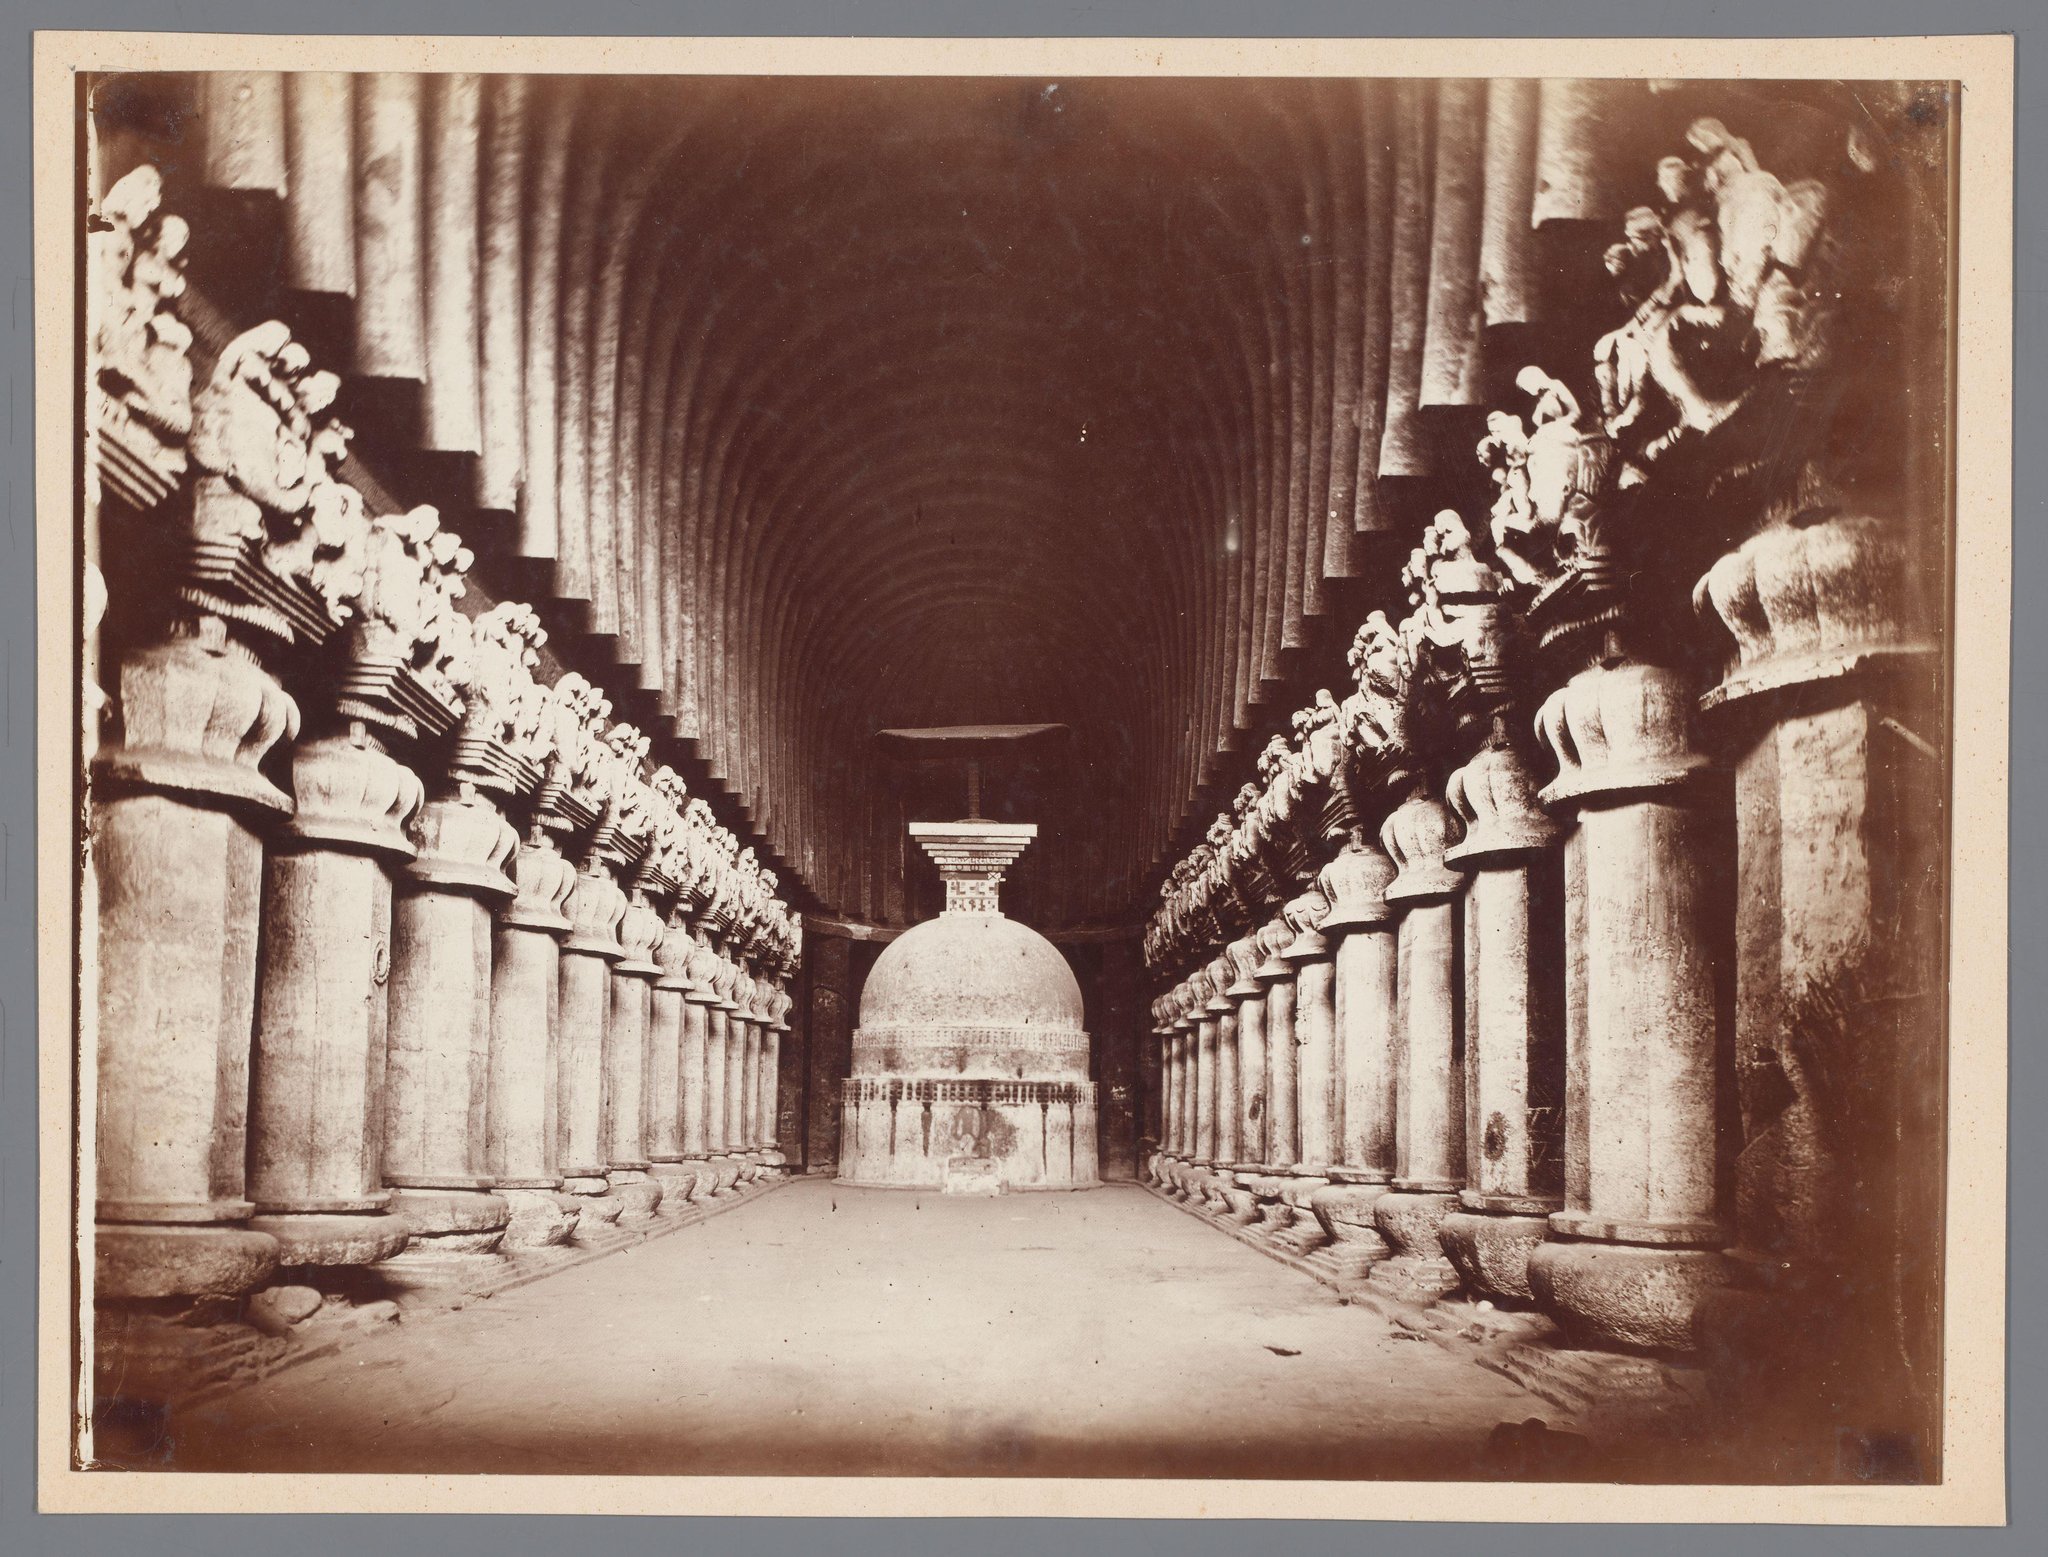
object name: photograph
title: Chaitya in the Karli caves near Mumbai, Maharashtra, India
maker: Anonymous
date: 1870-1890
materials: paper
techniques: gelatin silver print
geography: karli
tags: temple, shrine ~ hinduism, buddhism, jainism, cave, grotto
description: Deze foto toont de chaitya (het heiligdom) van de grootste van een groep grotten in Karli, in de West-Indiase deelstaat van Maharastra. Deze grot is van oorsprong boeddhistisch en wordt geassocieerd met een van de scholen van het vroege boeddhisme, genaamd Mahāsāṃghika. Op deze foto ziet men de stoepa, uit 120 n. Chr., met een parapluvormig deksel dat zeldzaam is onder deze grotten. Buiten de grot ligt een hindoetempel voor de godin Ekvira van de Koli, de vissers.